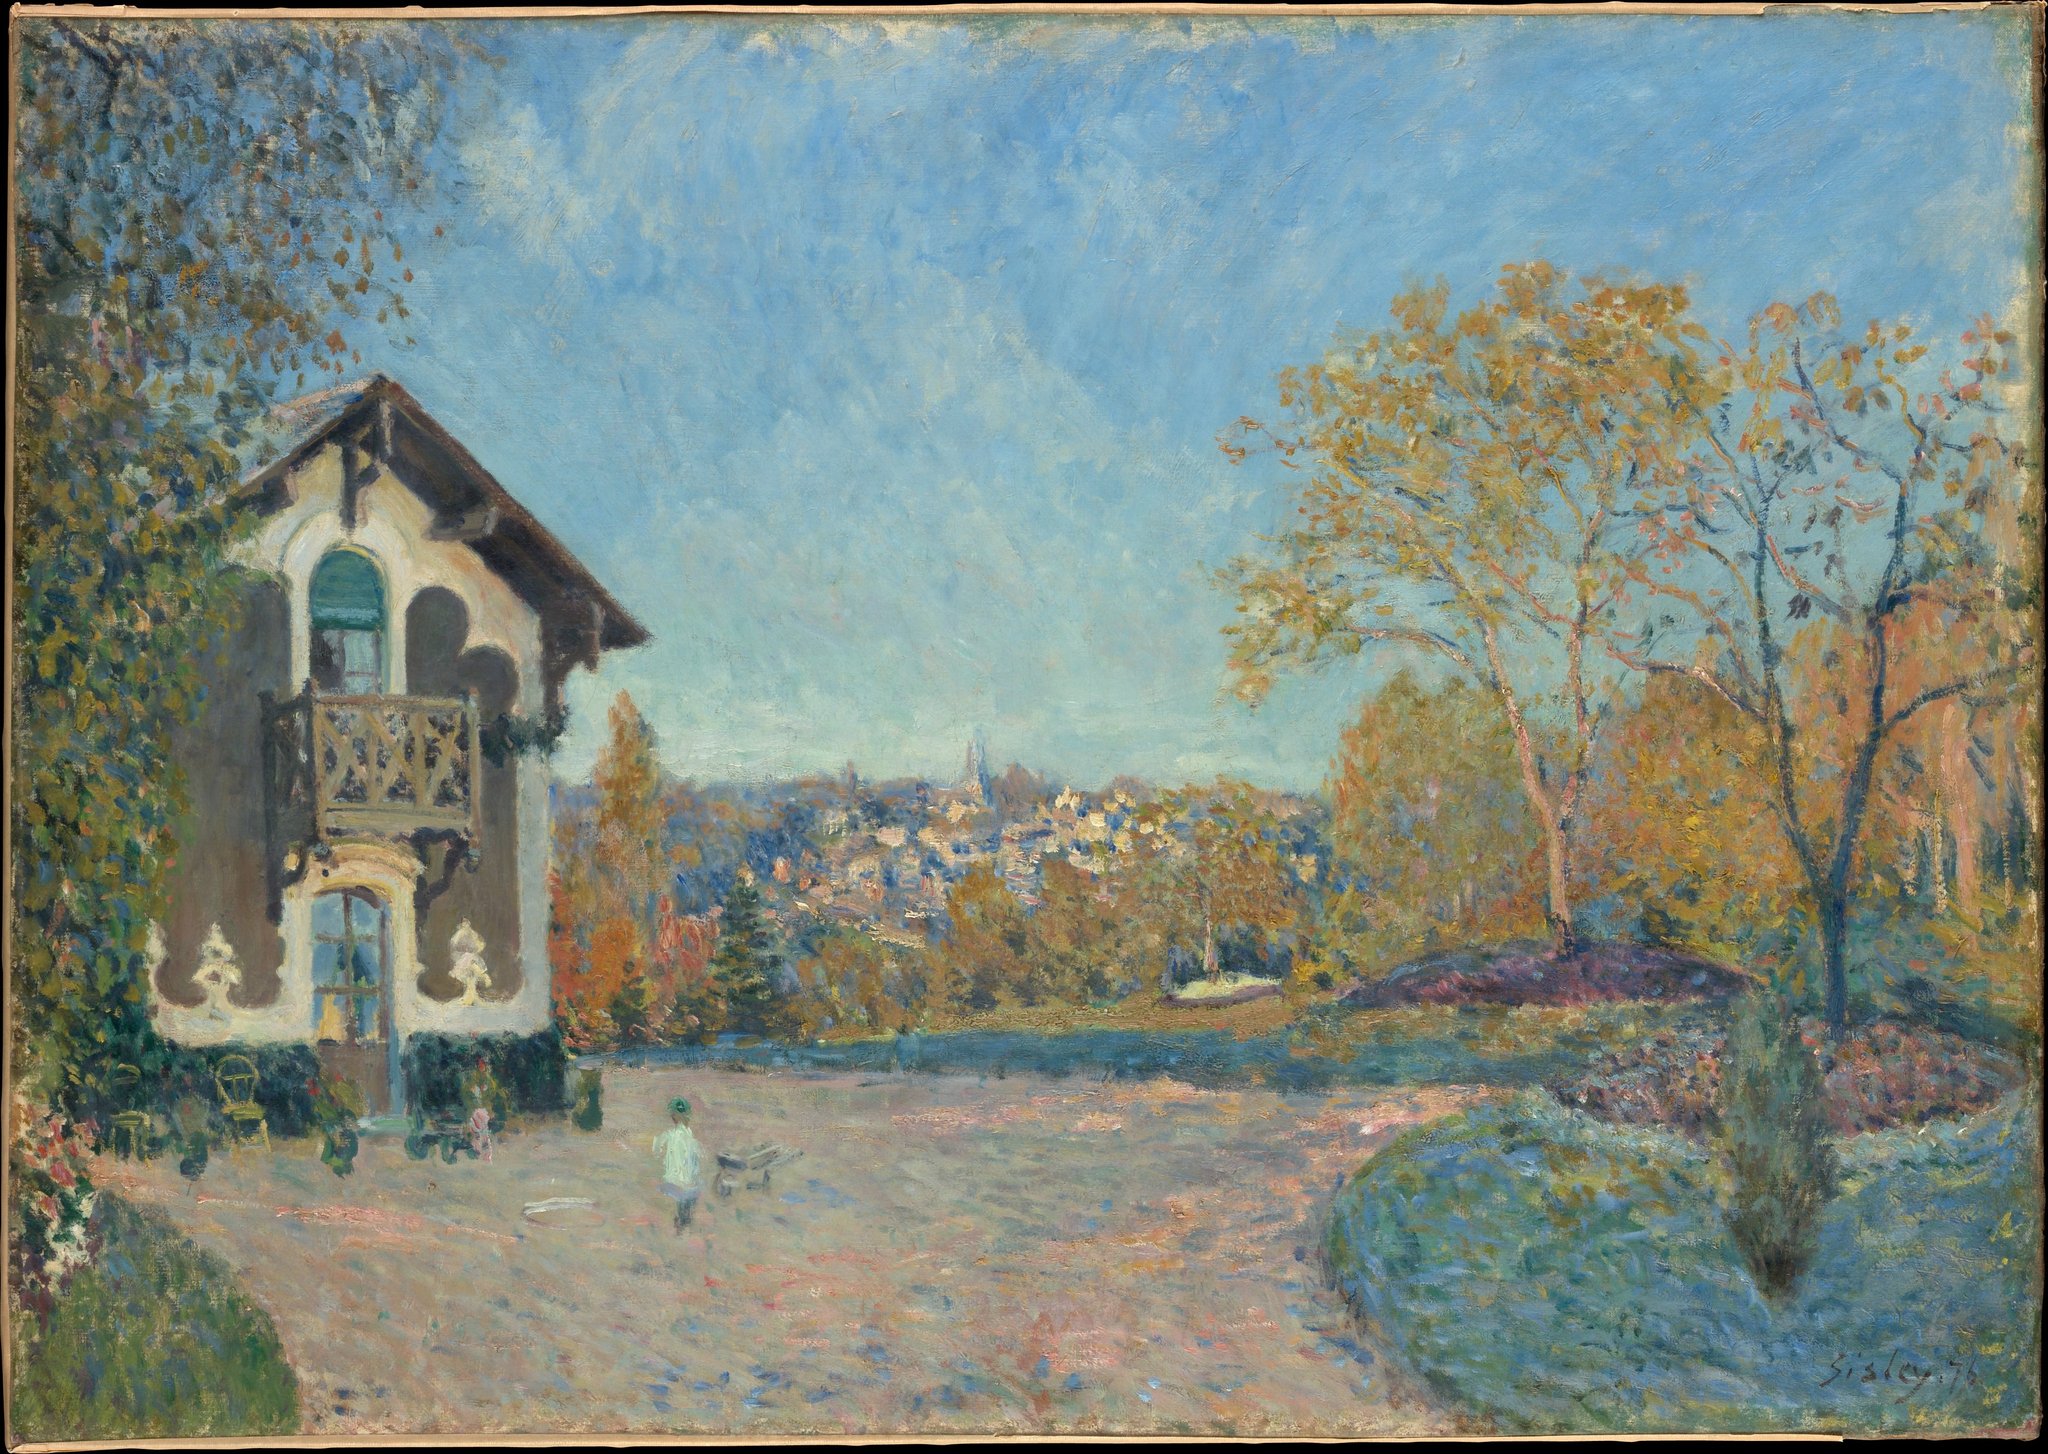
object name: painting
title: View of Marly-le-Roi from Coeur-Volant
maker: alfred sisley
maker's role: artist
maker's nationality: british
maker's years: 1839-1899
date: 1876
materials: canvas, oil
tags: gardens,towns